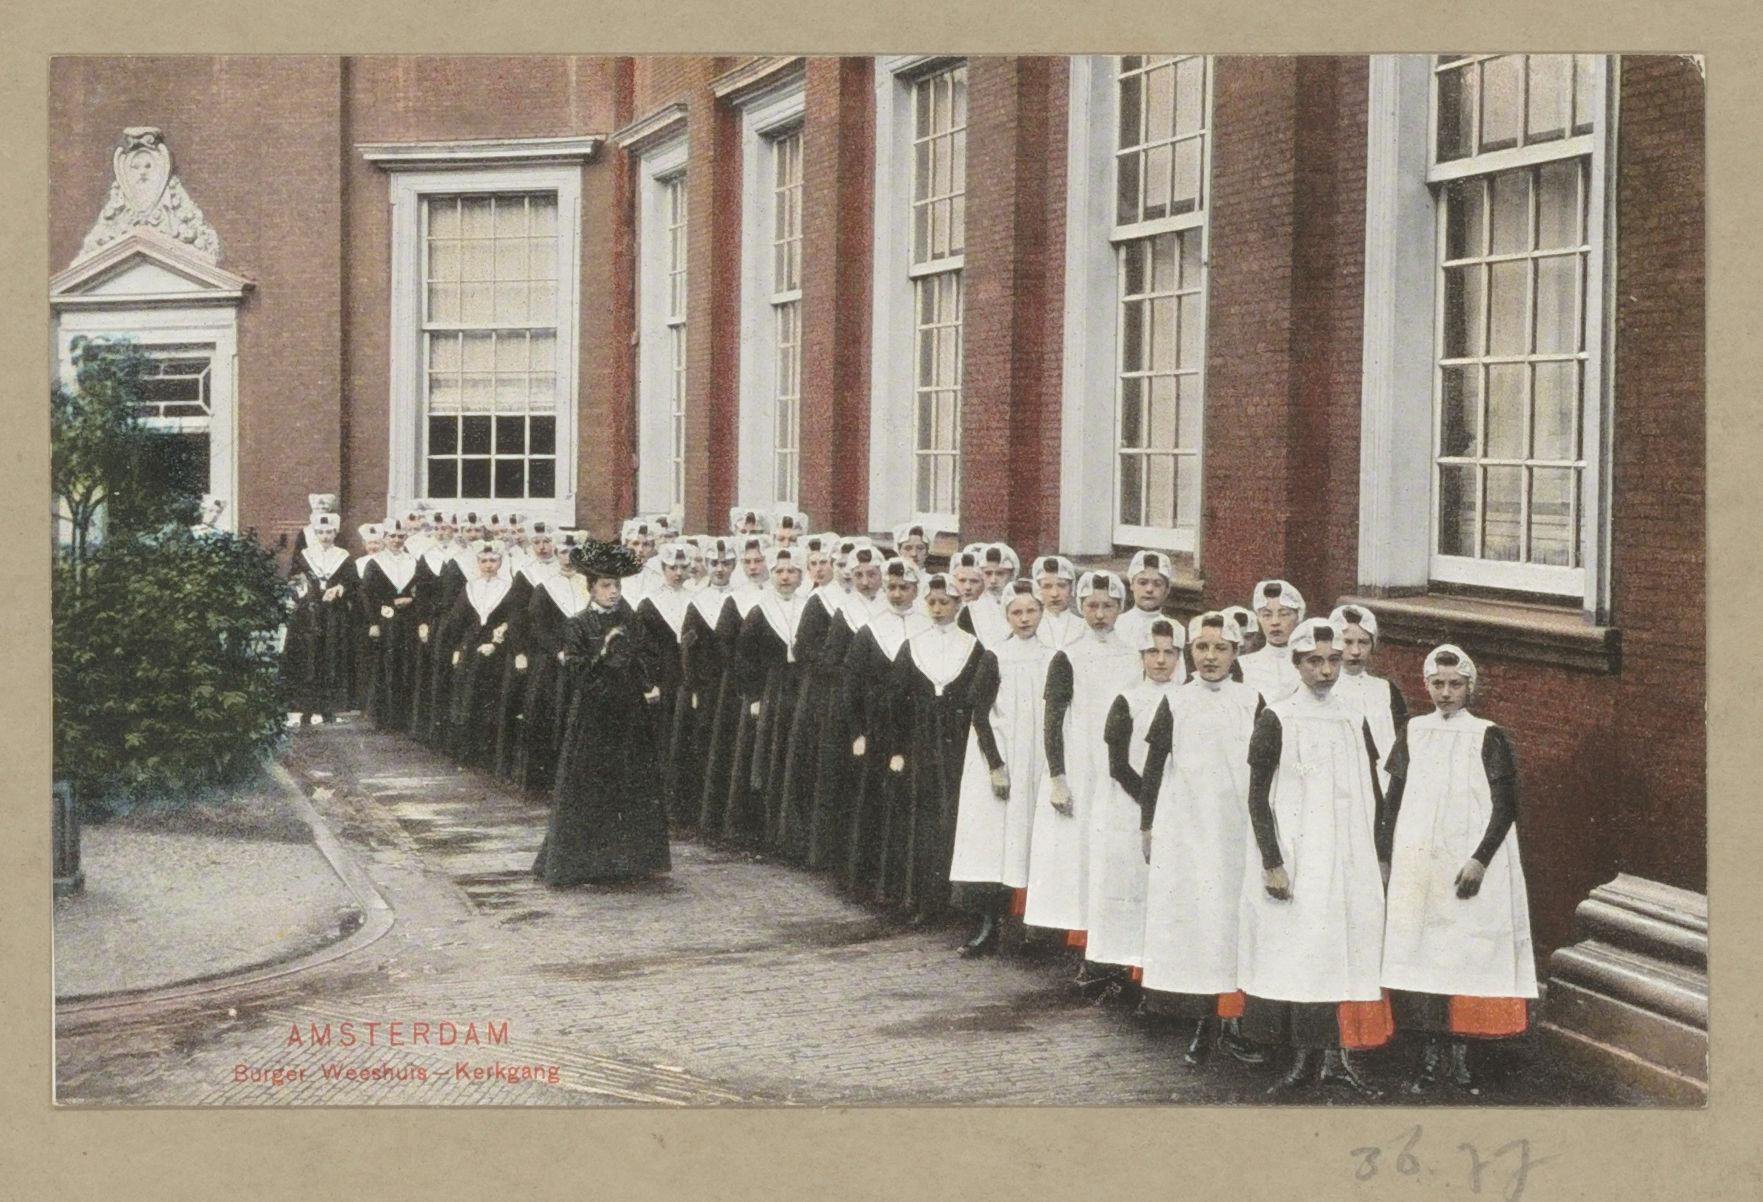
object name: ansichtkaart, prentbriefkaart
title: Weesmeisjes voor de kerkgang van het Burgerweeshuis te Amsterdam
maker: Anonymous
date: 1890-1920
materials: cardboard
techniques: four-color autotype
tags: orphanage, orphans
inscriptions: collector's mark: Lugt 1641b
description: Onderwerpsrubriek binnen de Atlas Amsterdam: Armwezen en liefdadige instellingen: I. Stadsinrichtingen: Burgerweeshuis.